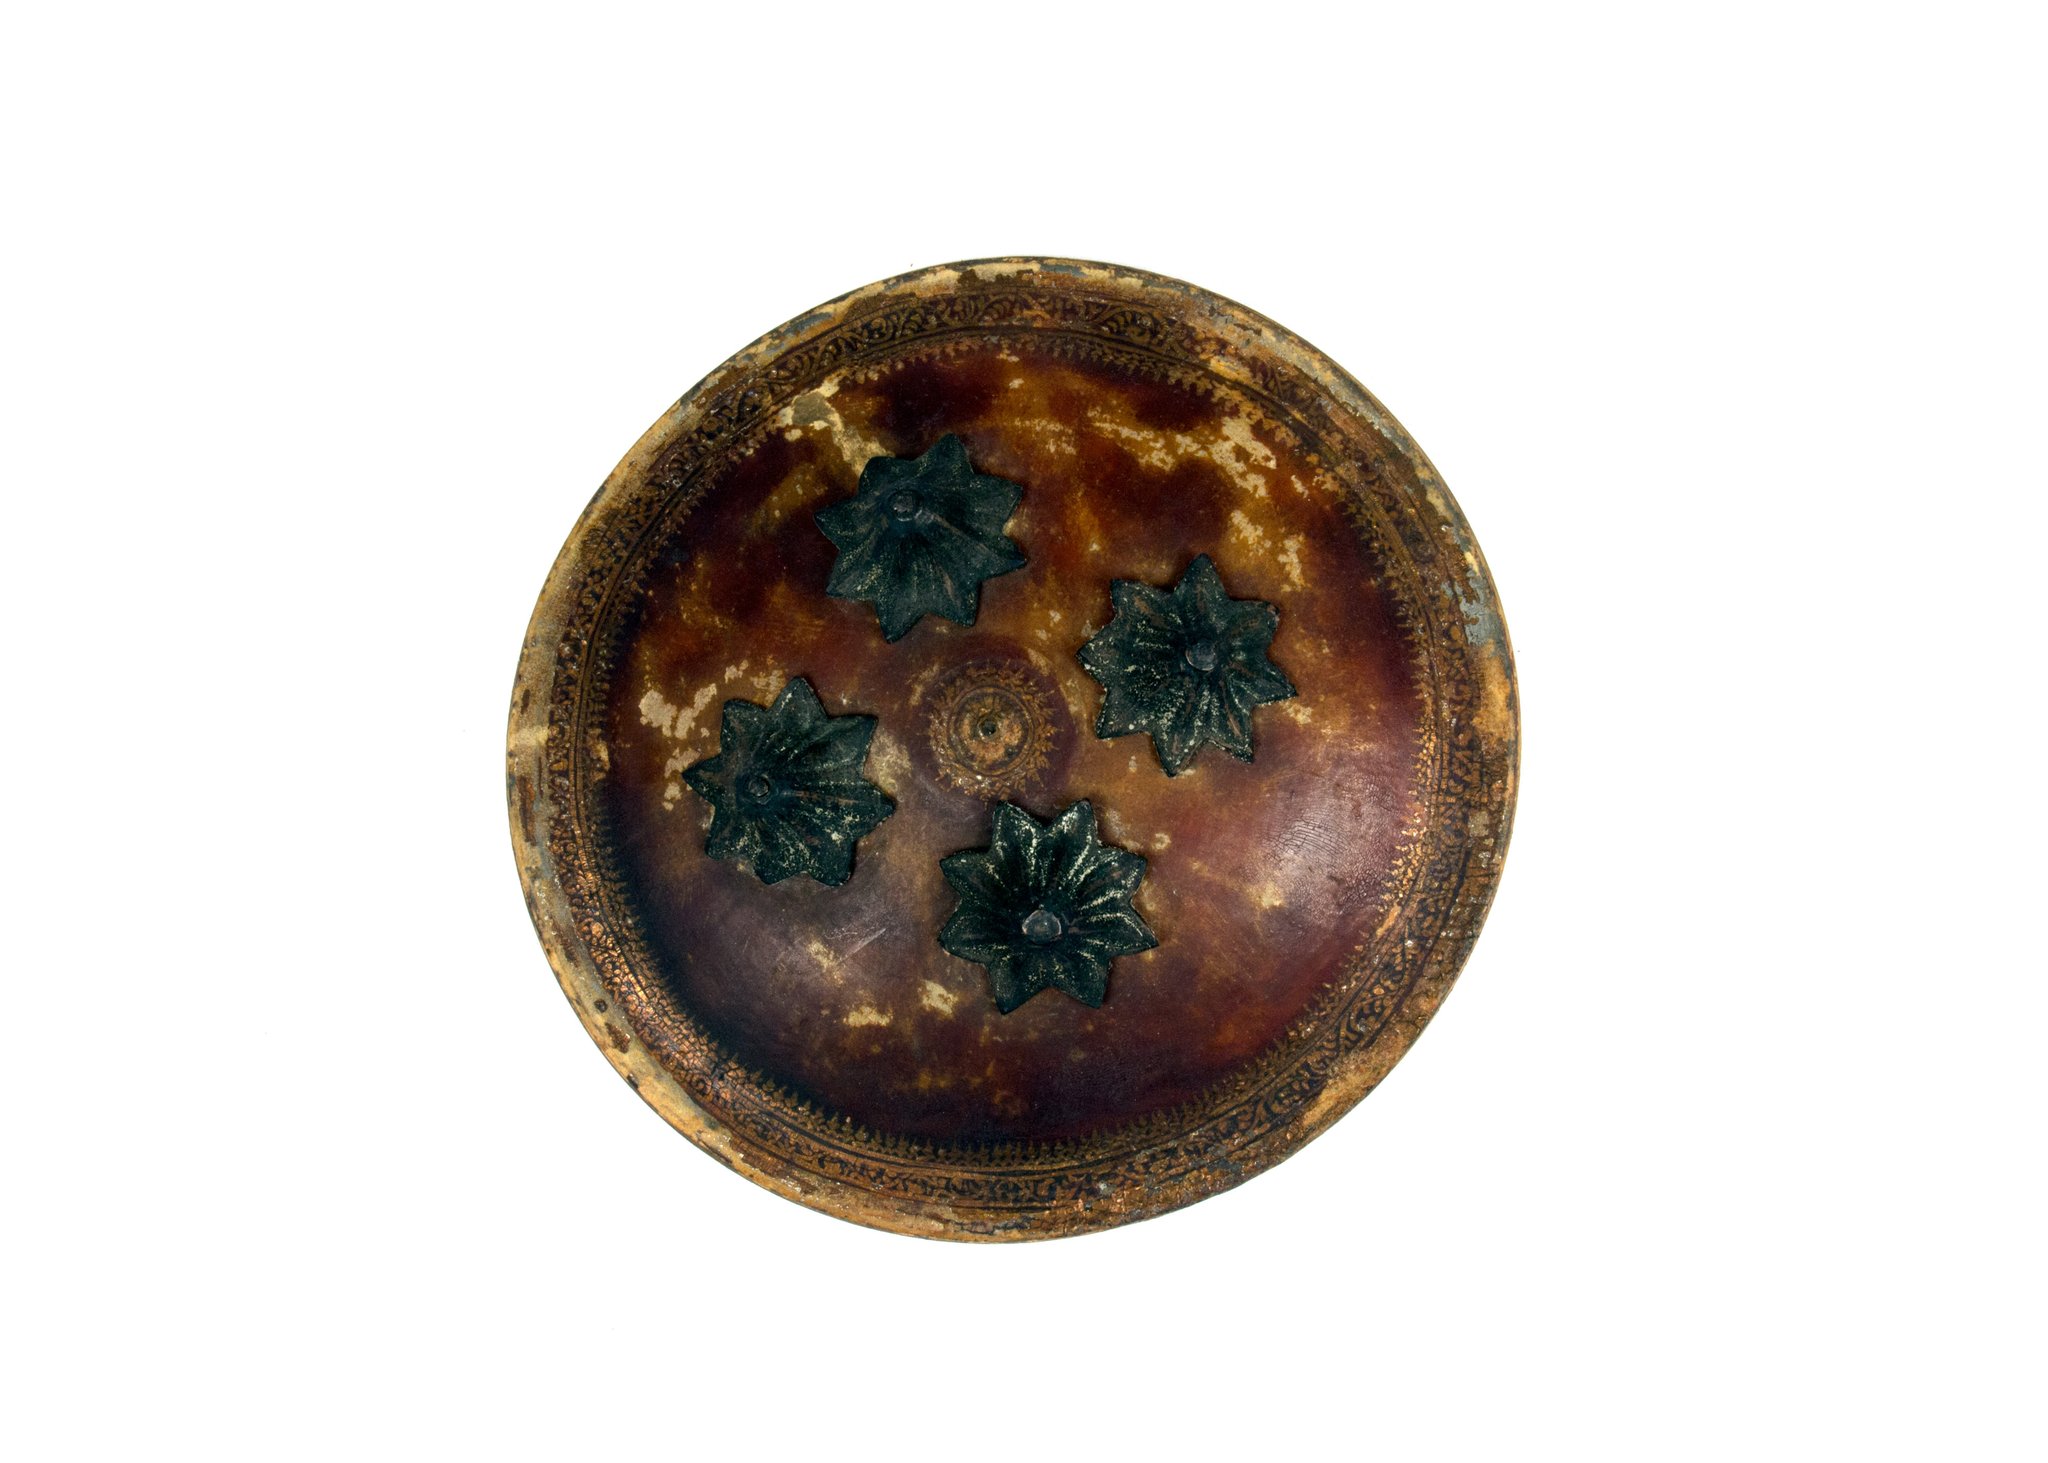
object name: shield dhàl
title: Shield (Dhàl)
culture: indian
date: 1801-1900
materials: copper alloy, gold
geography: india